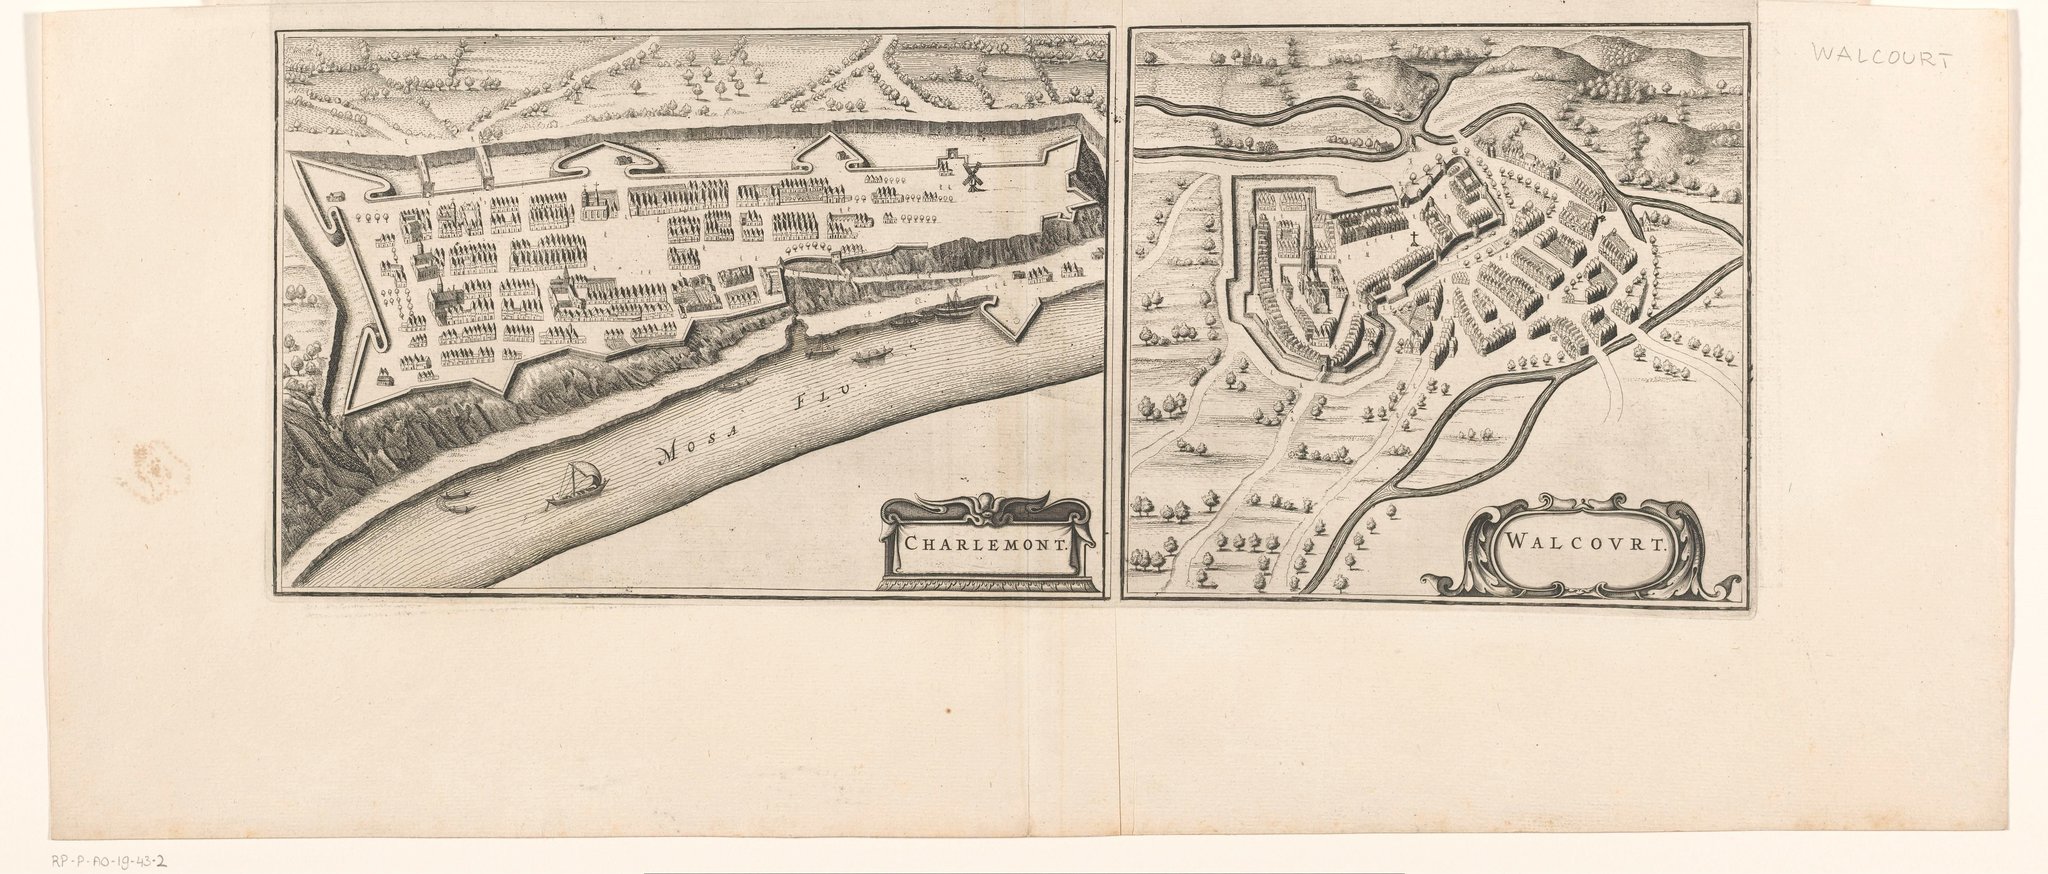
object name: area plan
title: Gezicht op Dinant en plattegrond van Walcourt en het fort Charlemont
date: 1652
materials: paper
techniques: engraving, etching, letterpress printing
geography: amsterdam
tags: maps of cities, coat of arms (as symbol of the state, etc.) (+ province; provincial), prospect of city, town panorama, silhouette of city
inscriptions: collector's mark: Lugt 2228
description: Boven een gezicht op Dinant, met rechtsboven een cartouche met het wapen van Dinant. Rechtsonder een plattegrond van Walcourt in vogelvluchtperspectief. De titelcartouche rechtsonder. Linksonder een plattegrond van het fort Charlemont in vogelvluchtperspectief. De titelcartouche rechtsonder. Met Latijnse tekst op verso.